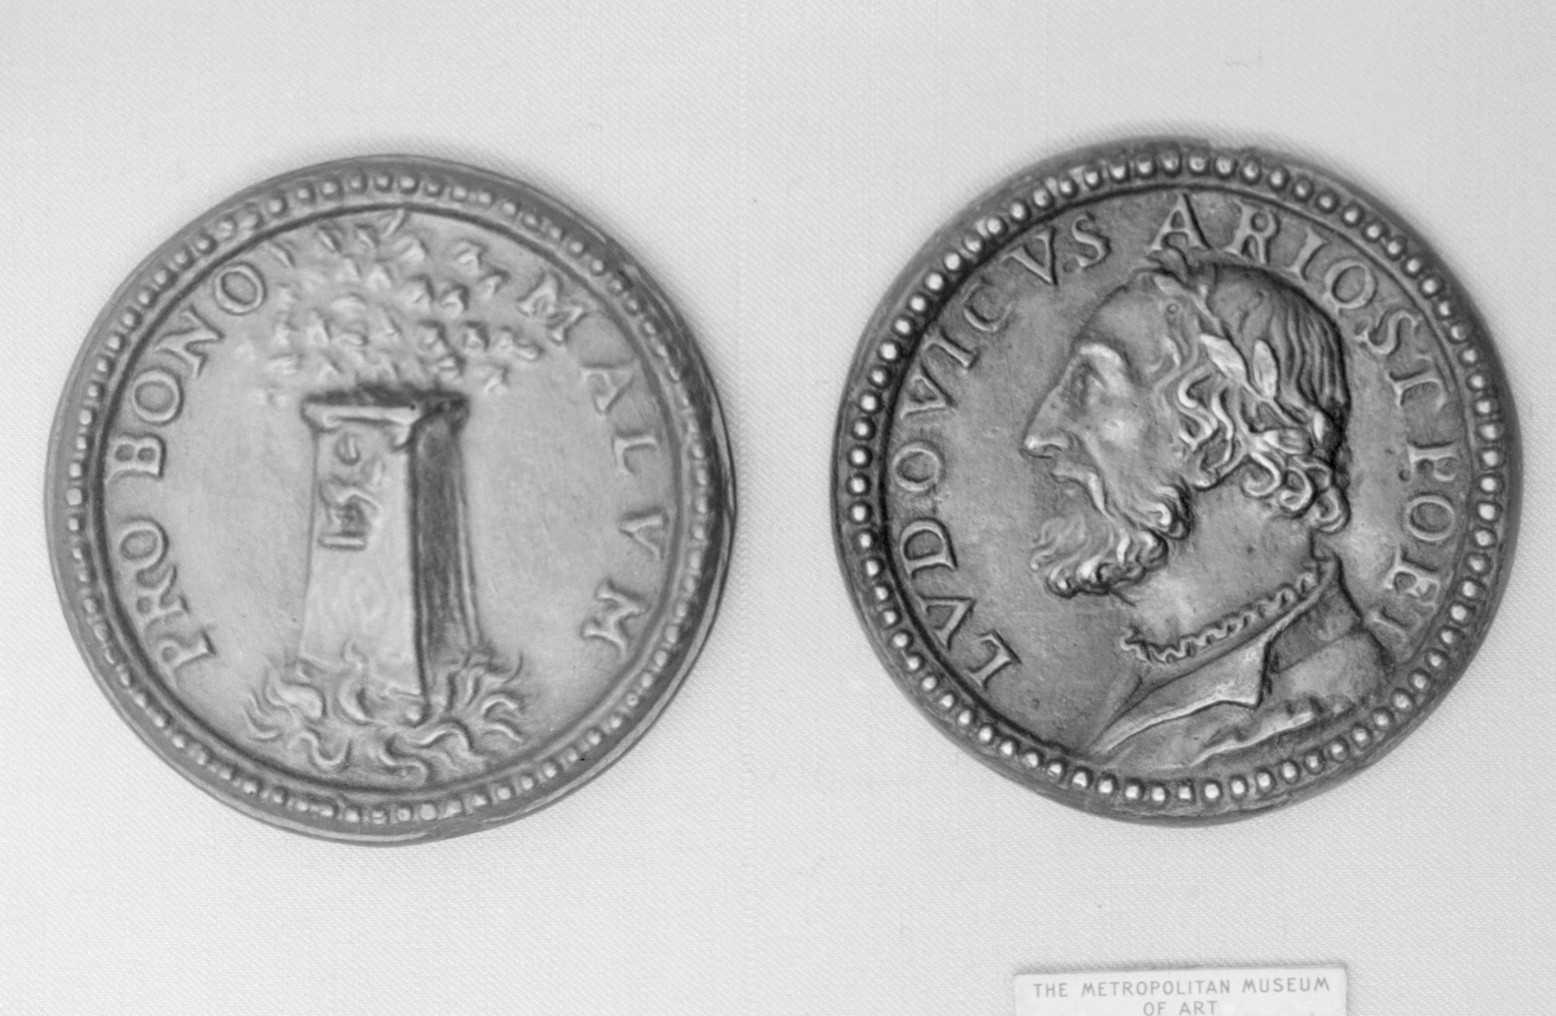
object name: medal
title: Lodovico Ariosto of Ferrara (1474–1533)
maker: pastorino di giovan michele de' pastorini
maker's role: artist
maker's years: 1508-1592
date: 1555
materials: bronze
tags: men,profiles